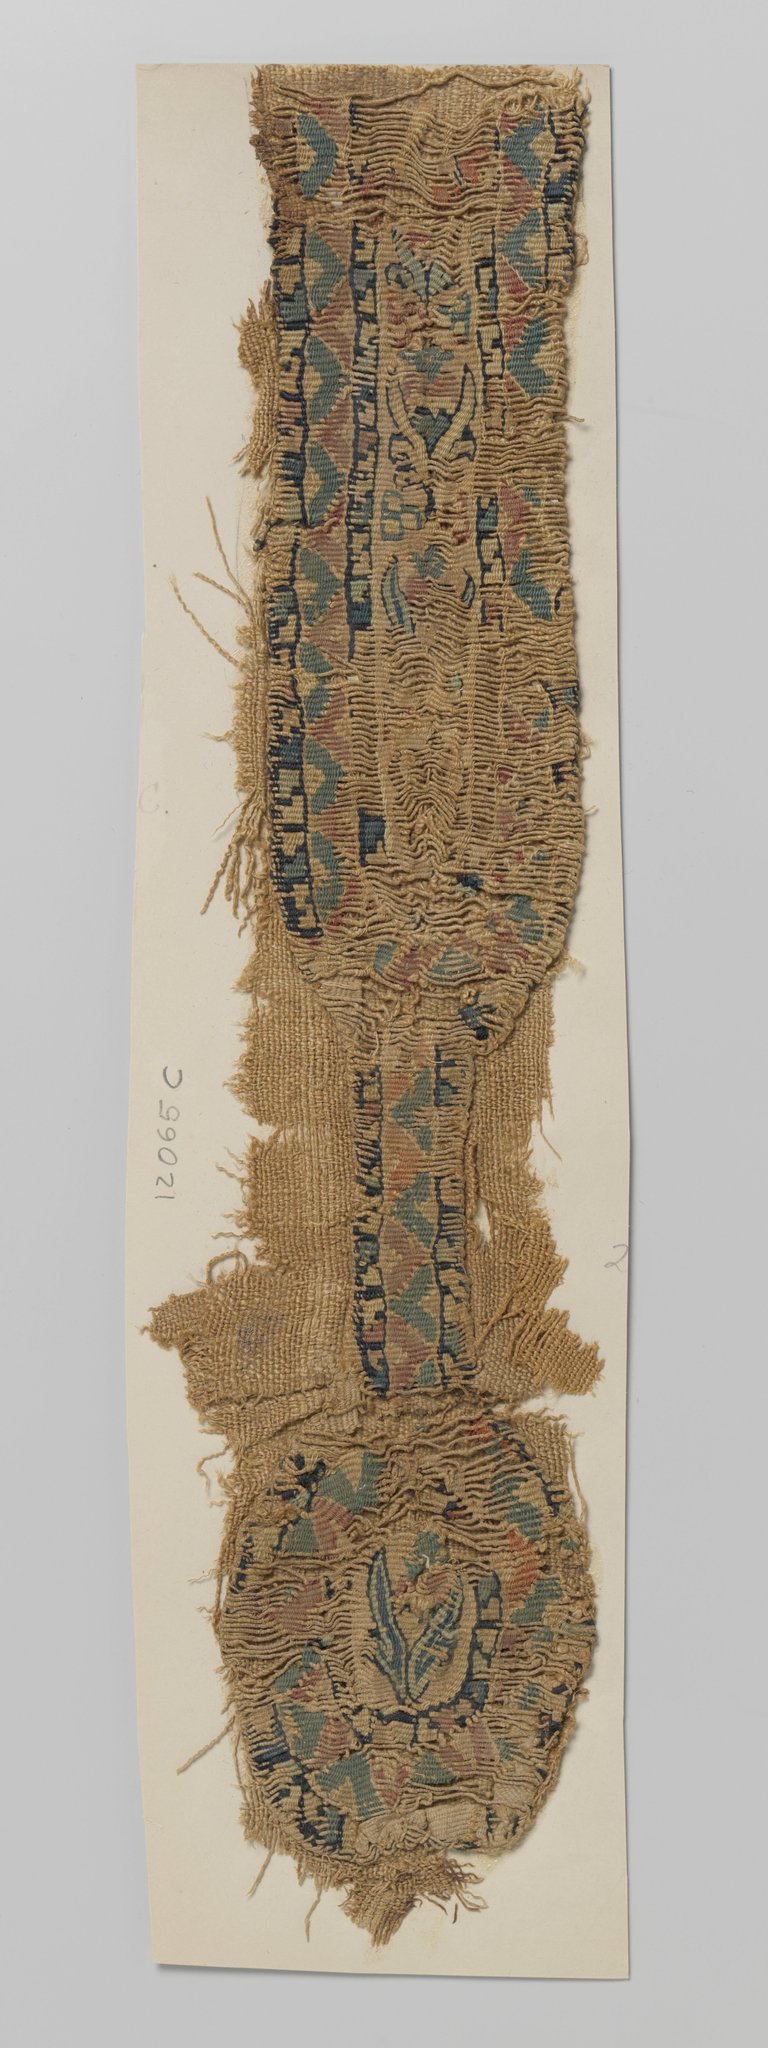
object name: sigillum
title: Weefselfragment met clavus en sigillum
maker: Anonymous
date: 500-699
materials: linen, wool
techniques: weave, tapestry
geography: egypt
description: Naturelkleurig linnen weefselfragment met opgenaaide clavus en sigillum, gedecoreerd met bloem- en bladmotieven en omgeven door een rand met geometrische versiering in groen, rood, licht- en donkerblauw en geel.